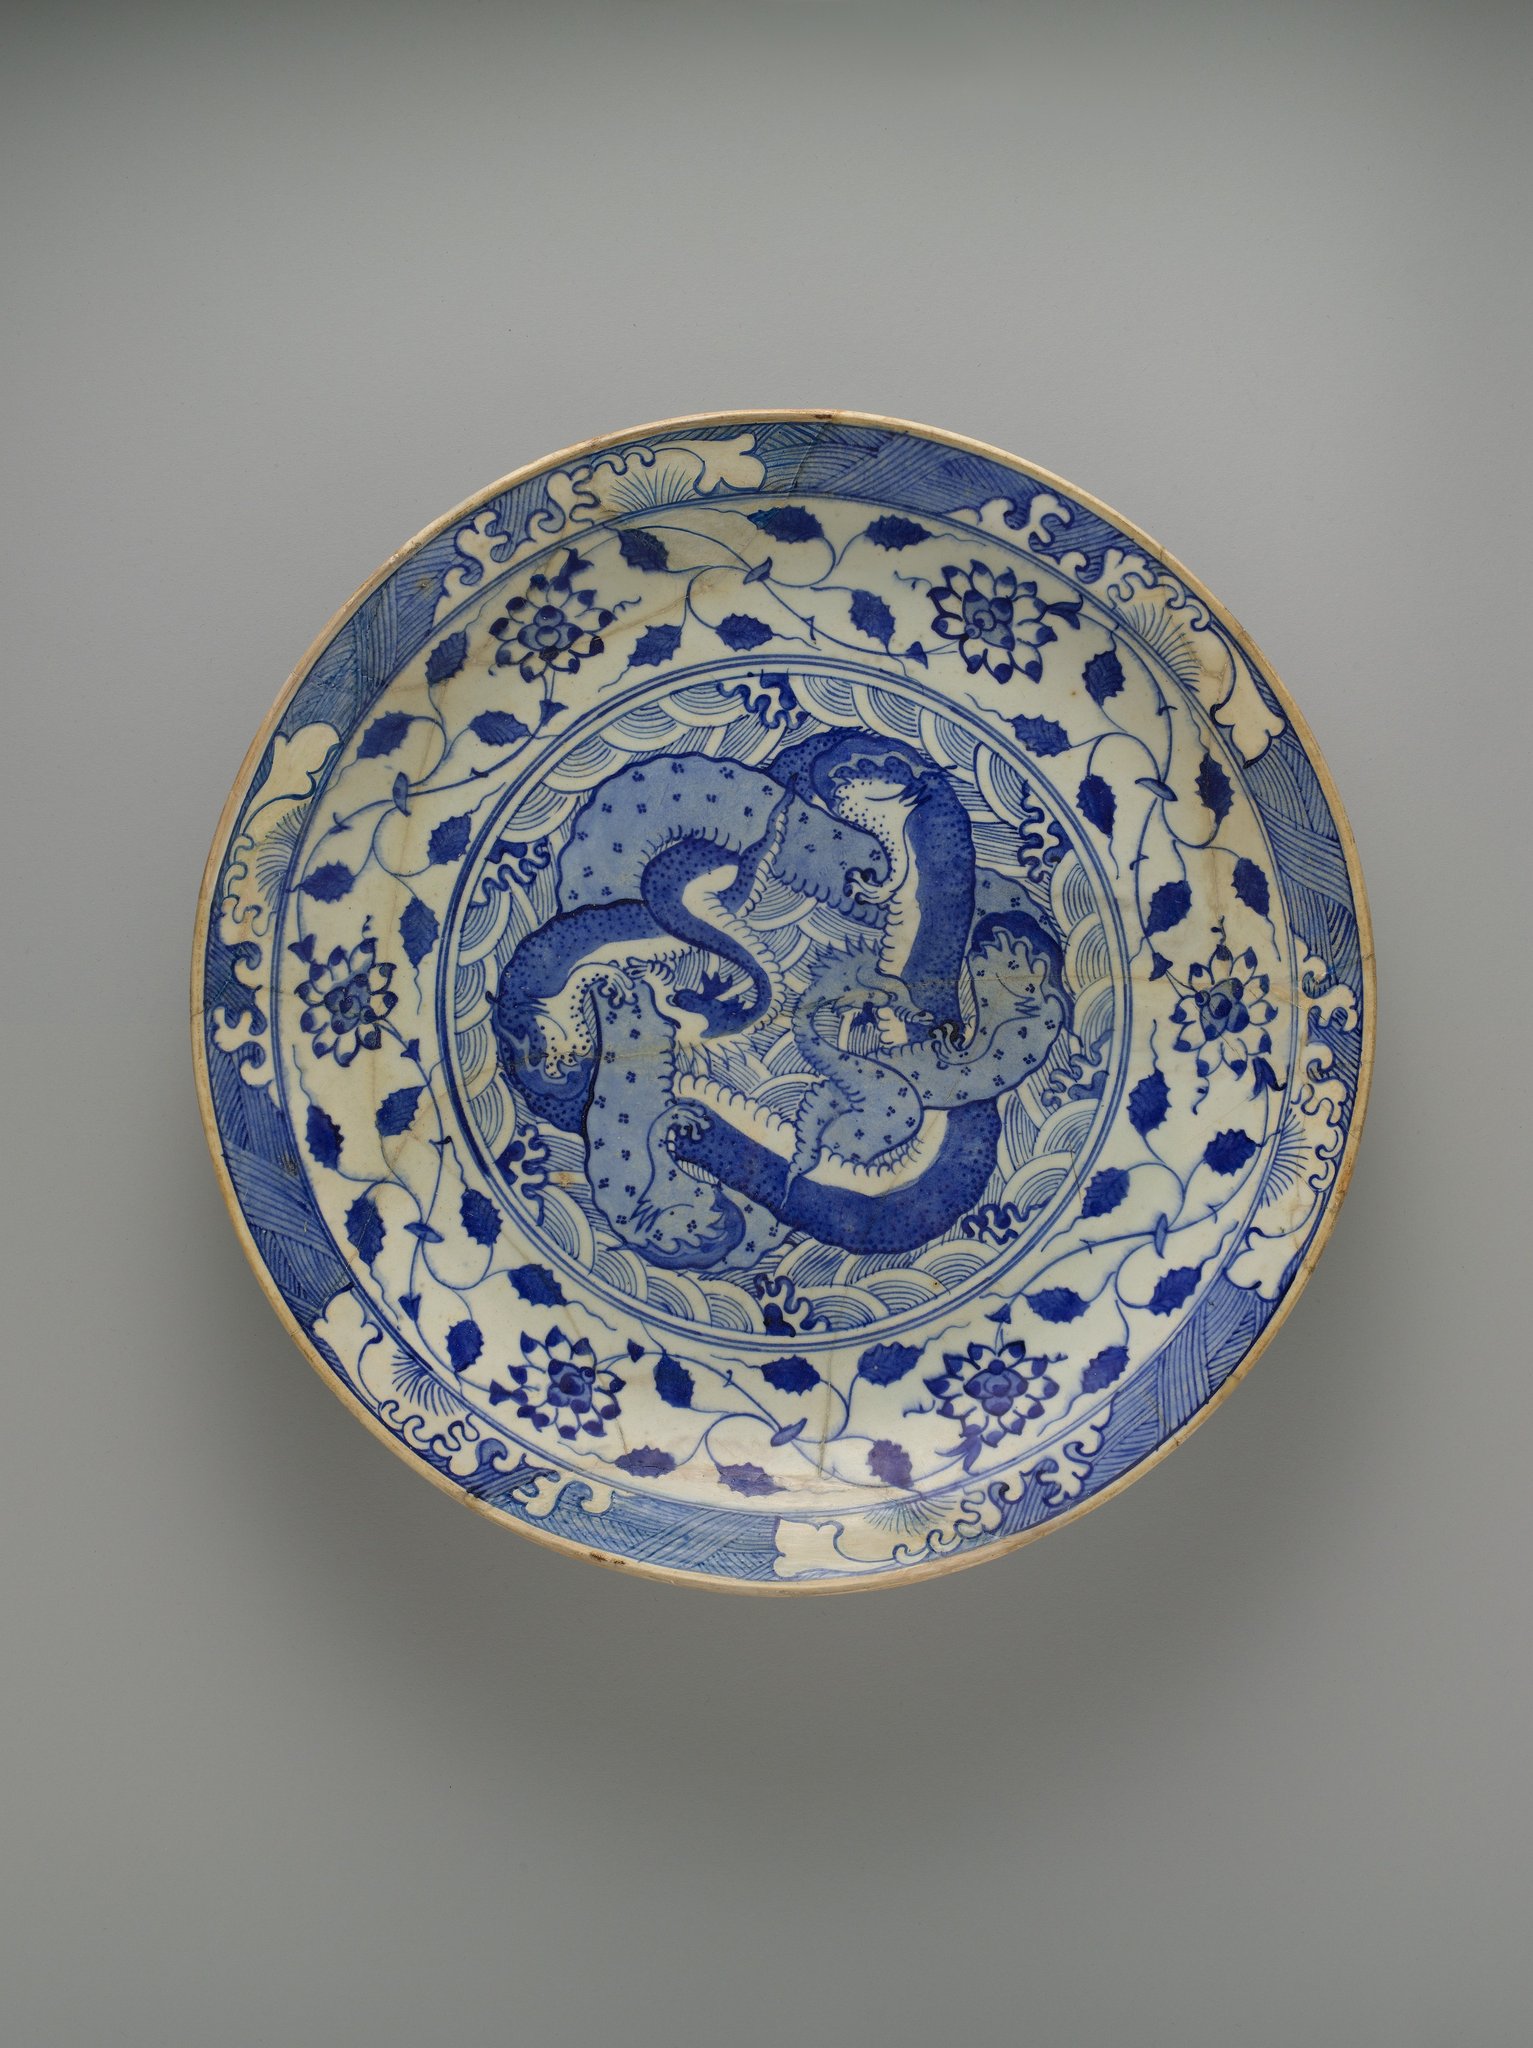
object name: dish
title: Dish with Two Intertwined Dragons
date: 1640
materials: glaze, stonepaste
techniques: painting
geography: iran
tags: dragons